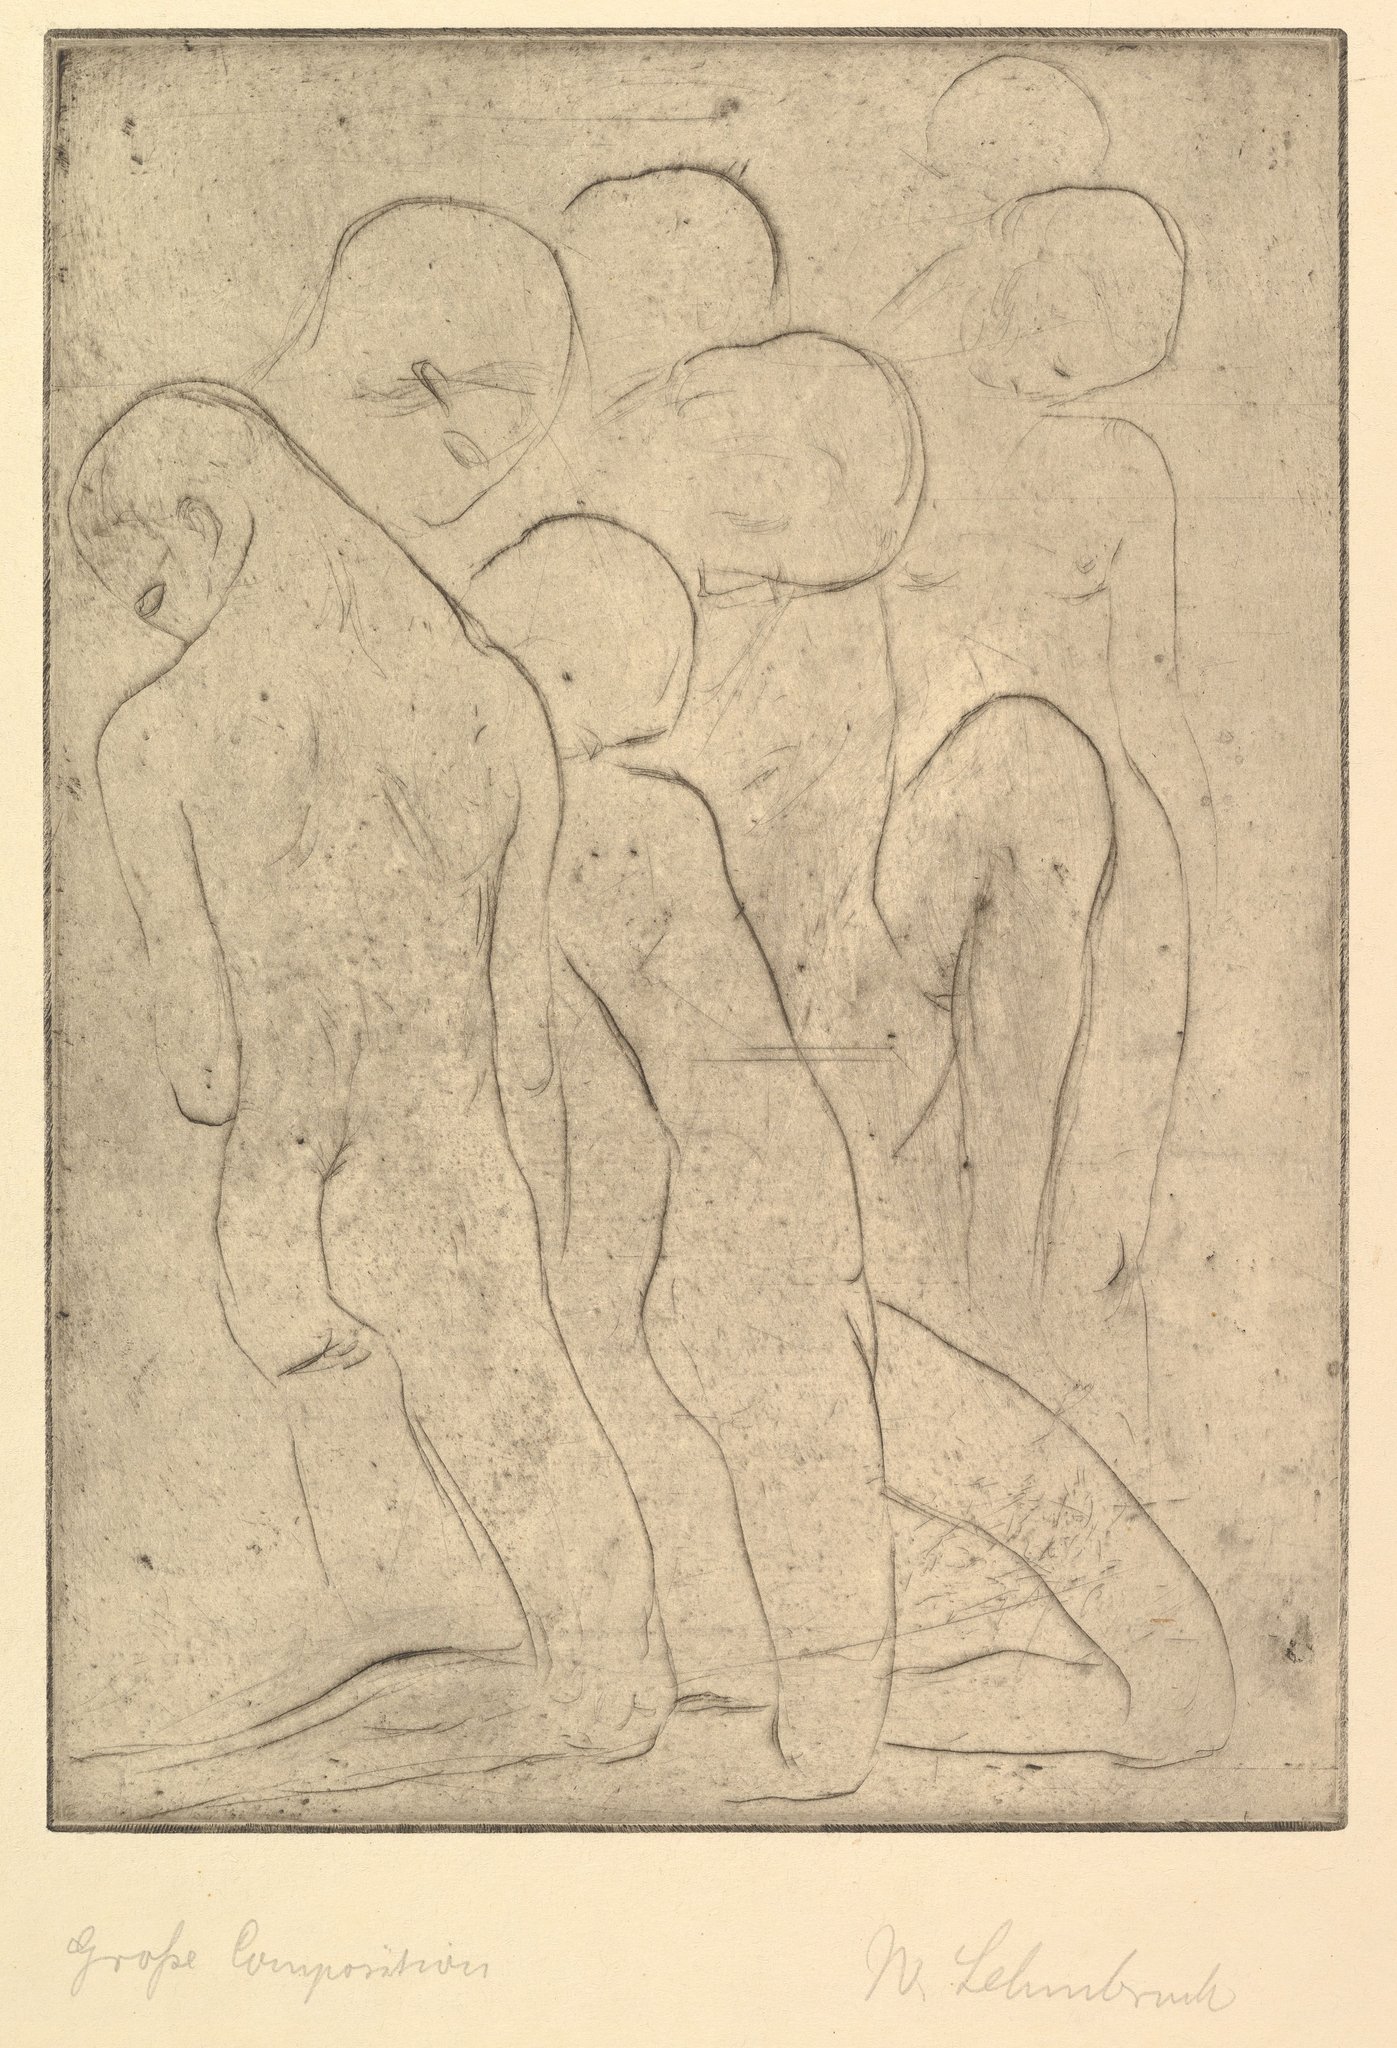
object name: print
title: Composition (Große Komposition)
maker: wilhelm lehmbruck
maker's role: artist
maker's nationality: german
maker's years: 1881-1919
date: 1913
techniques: drypoint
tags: human figures